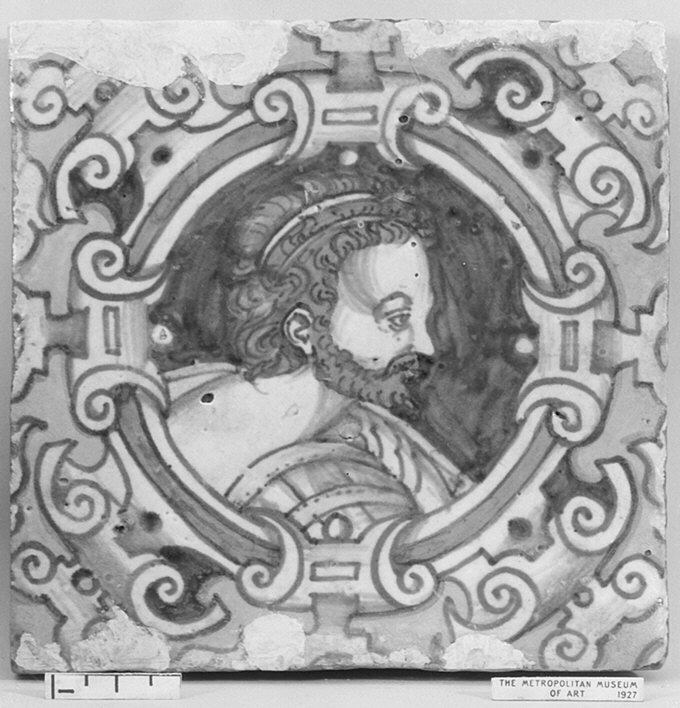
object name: tile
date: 1601-1650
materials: earthenware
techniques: glazing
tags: men,profiles